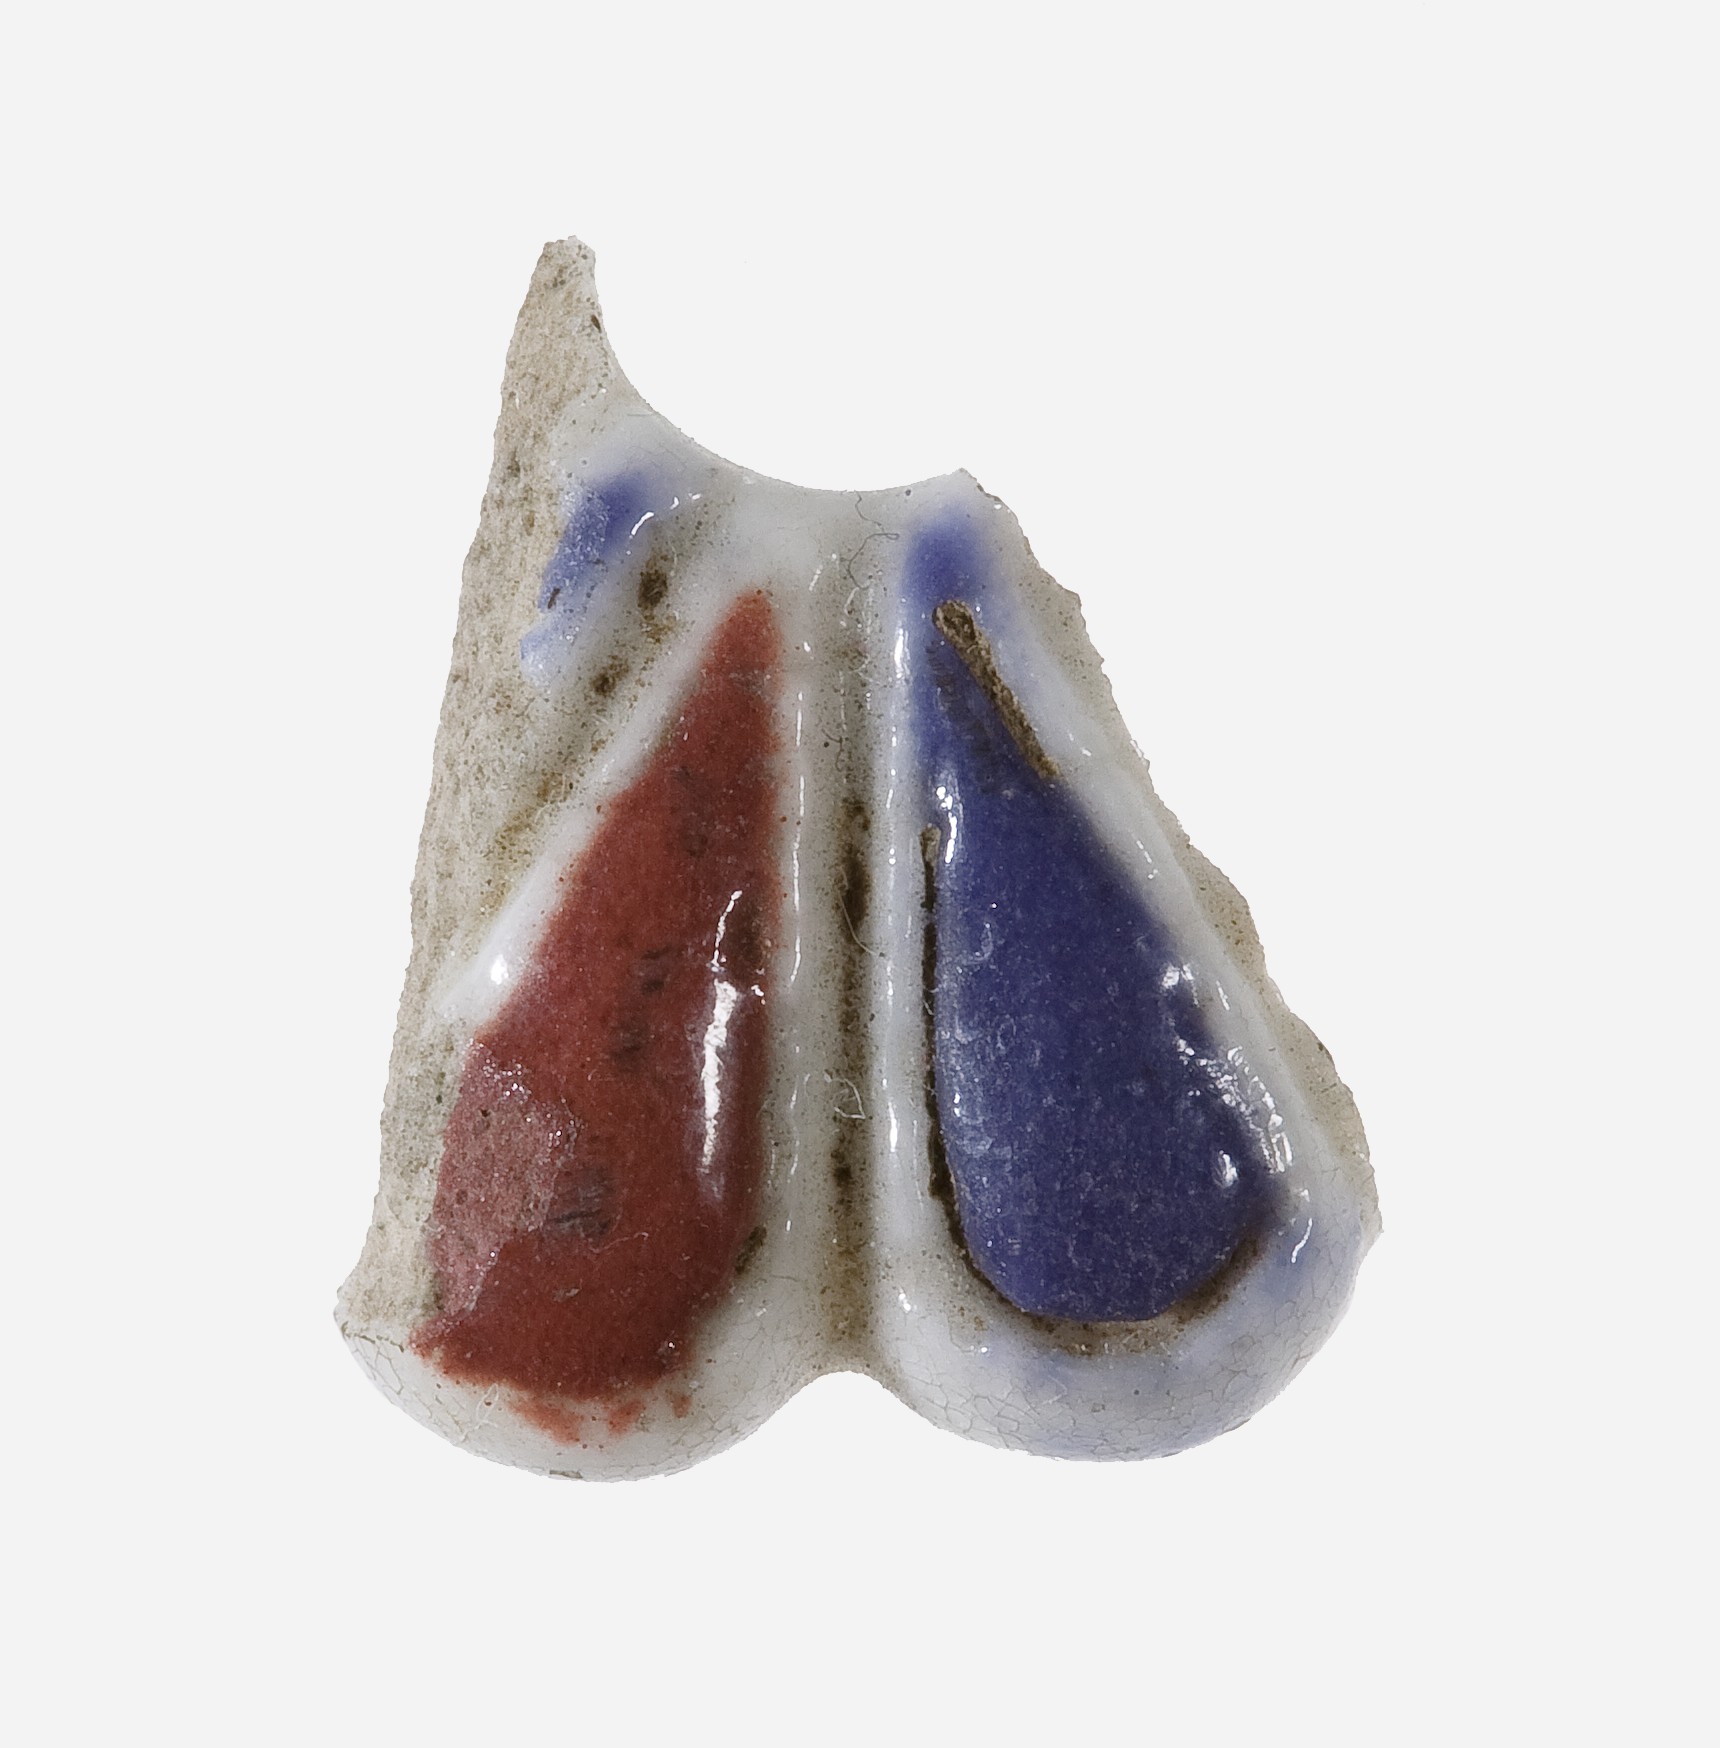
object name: bead, daisy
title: Fragment of a Bead in the Form of a Daisy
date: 1390-1352 BCE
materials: faience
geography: egypt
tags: daisies